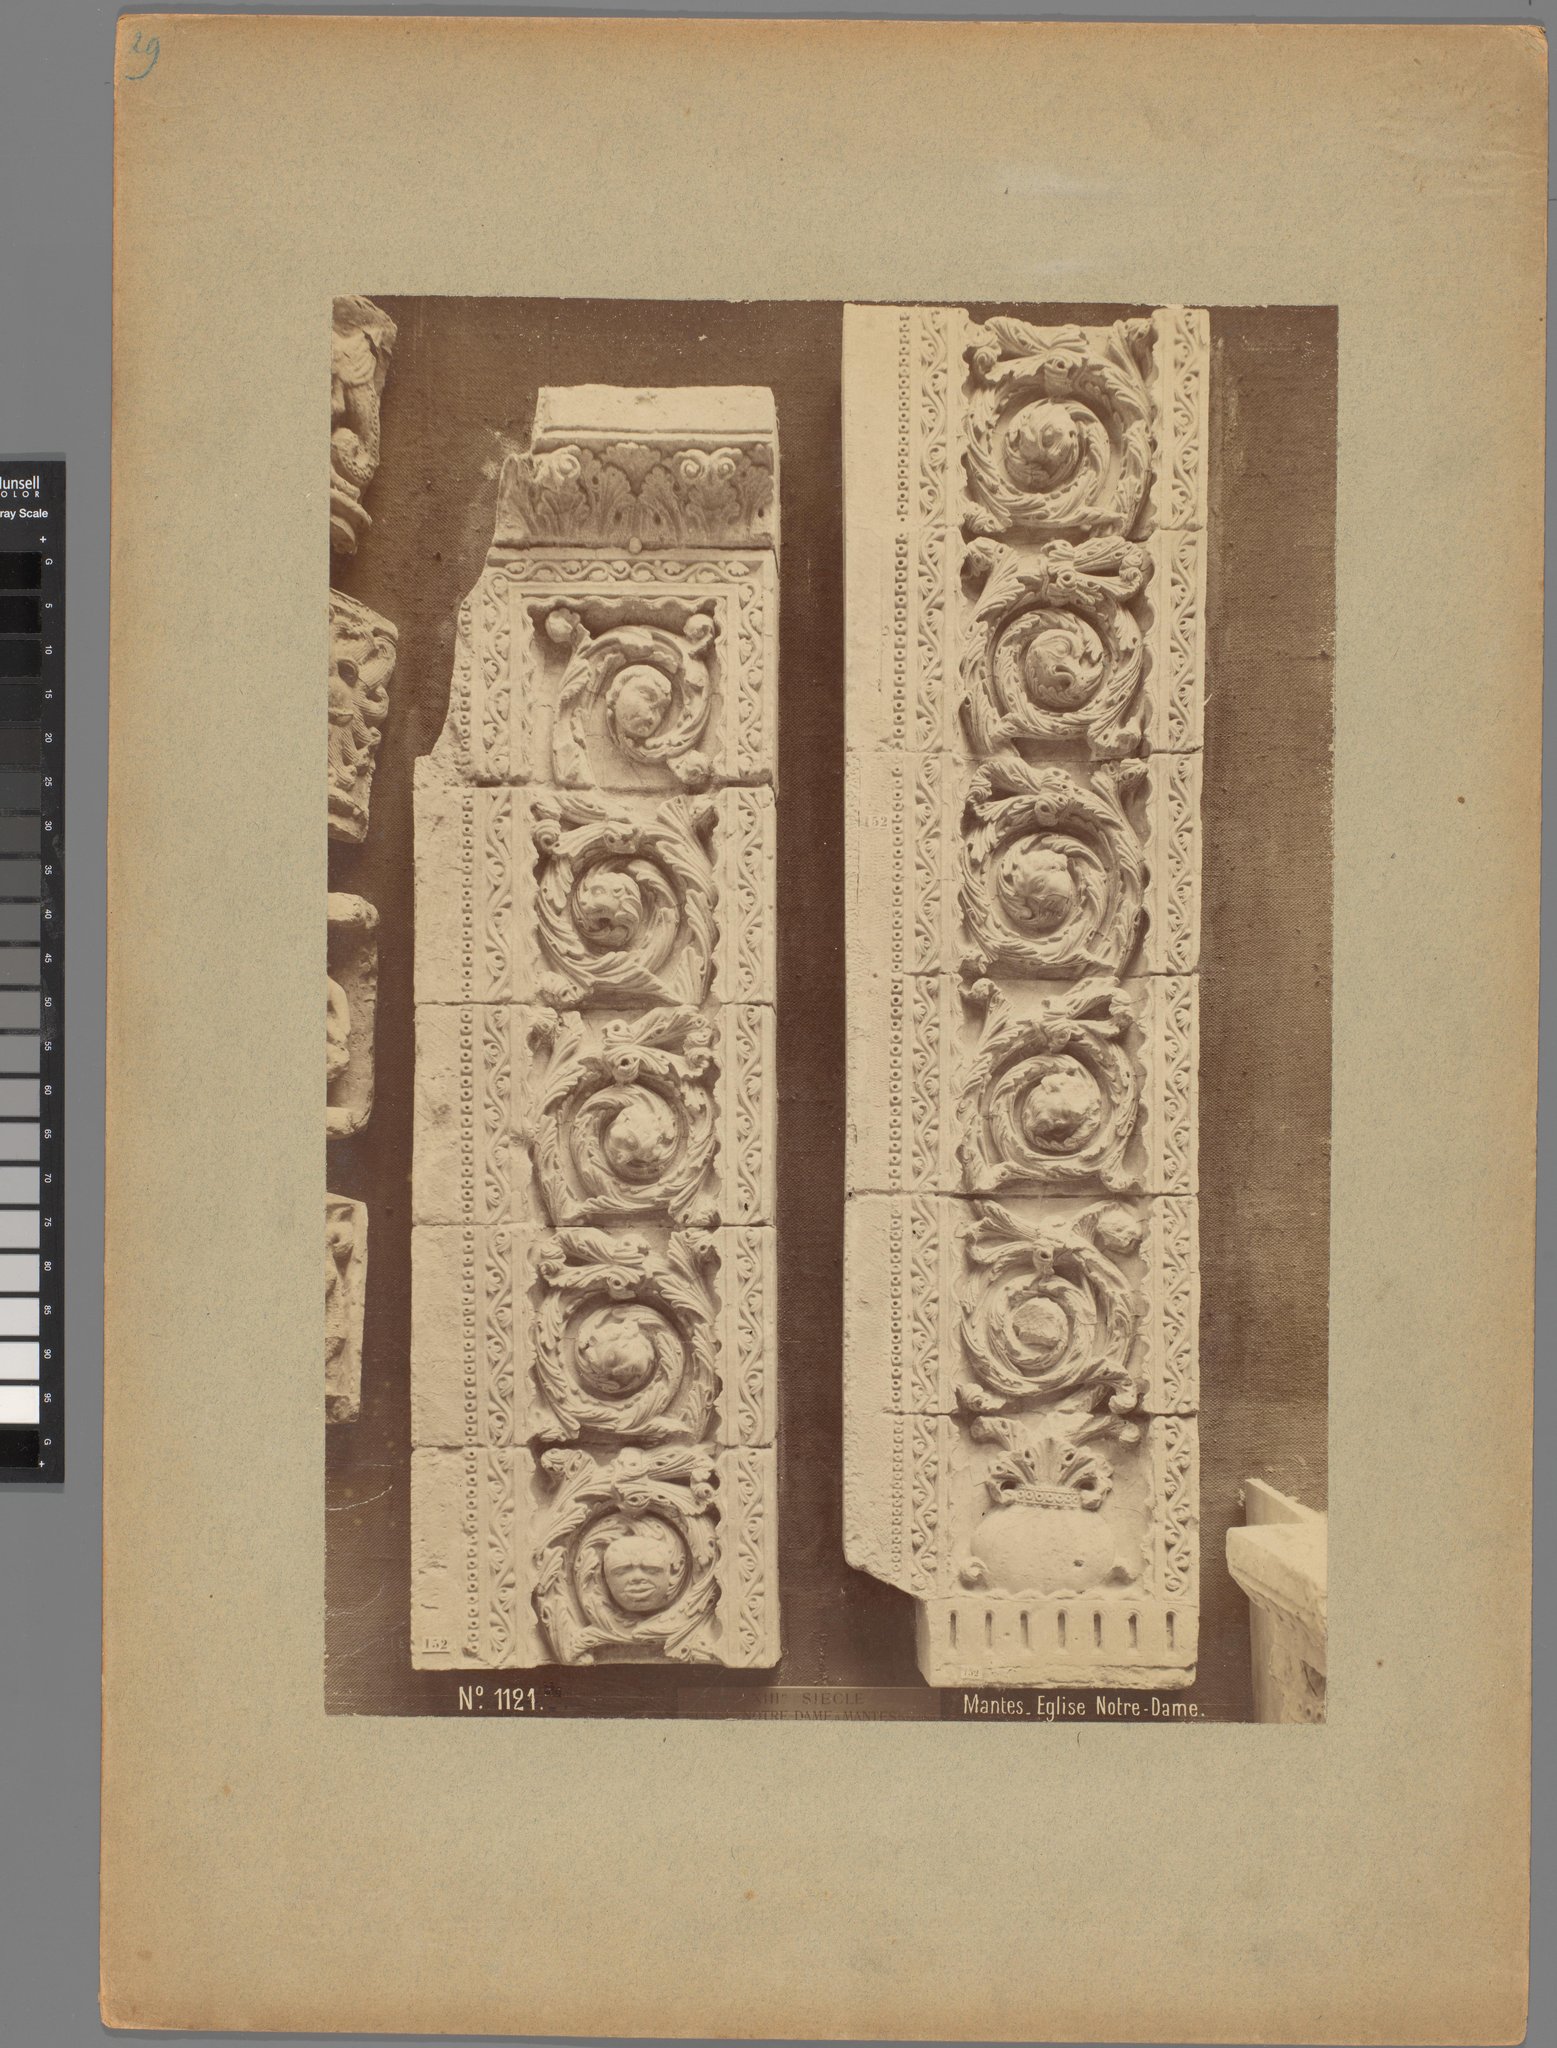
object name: photograph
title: Afgietsel van decoratie uit de Eglise Notre-Dame te Mantes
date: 1850-1900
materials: cardboard, photographic support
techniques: albumen print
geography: the hague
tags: ornament derived from plant forms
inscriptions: workshop stamp: ‘Kunsthandel/ J.A.G. de Leur/ Photograaf- Uitgever/ Huigenspark, 40b,/ Den Haag’, collector's mark: ‘Rijks-normaalschool voor teekenonderwijzers Amsterdam’, number: ‘No. 1121’